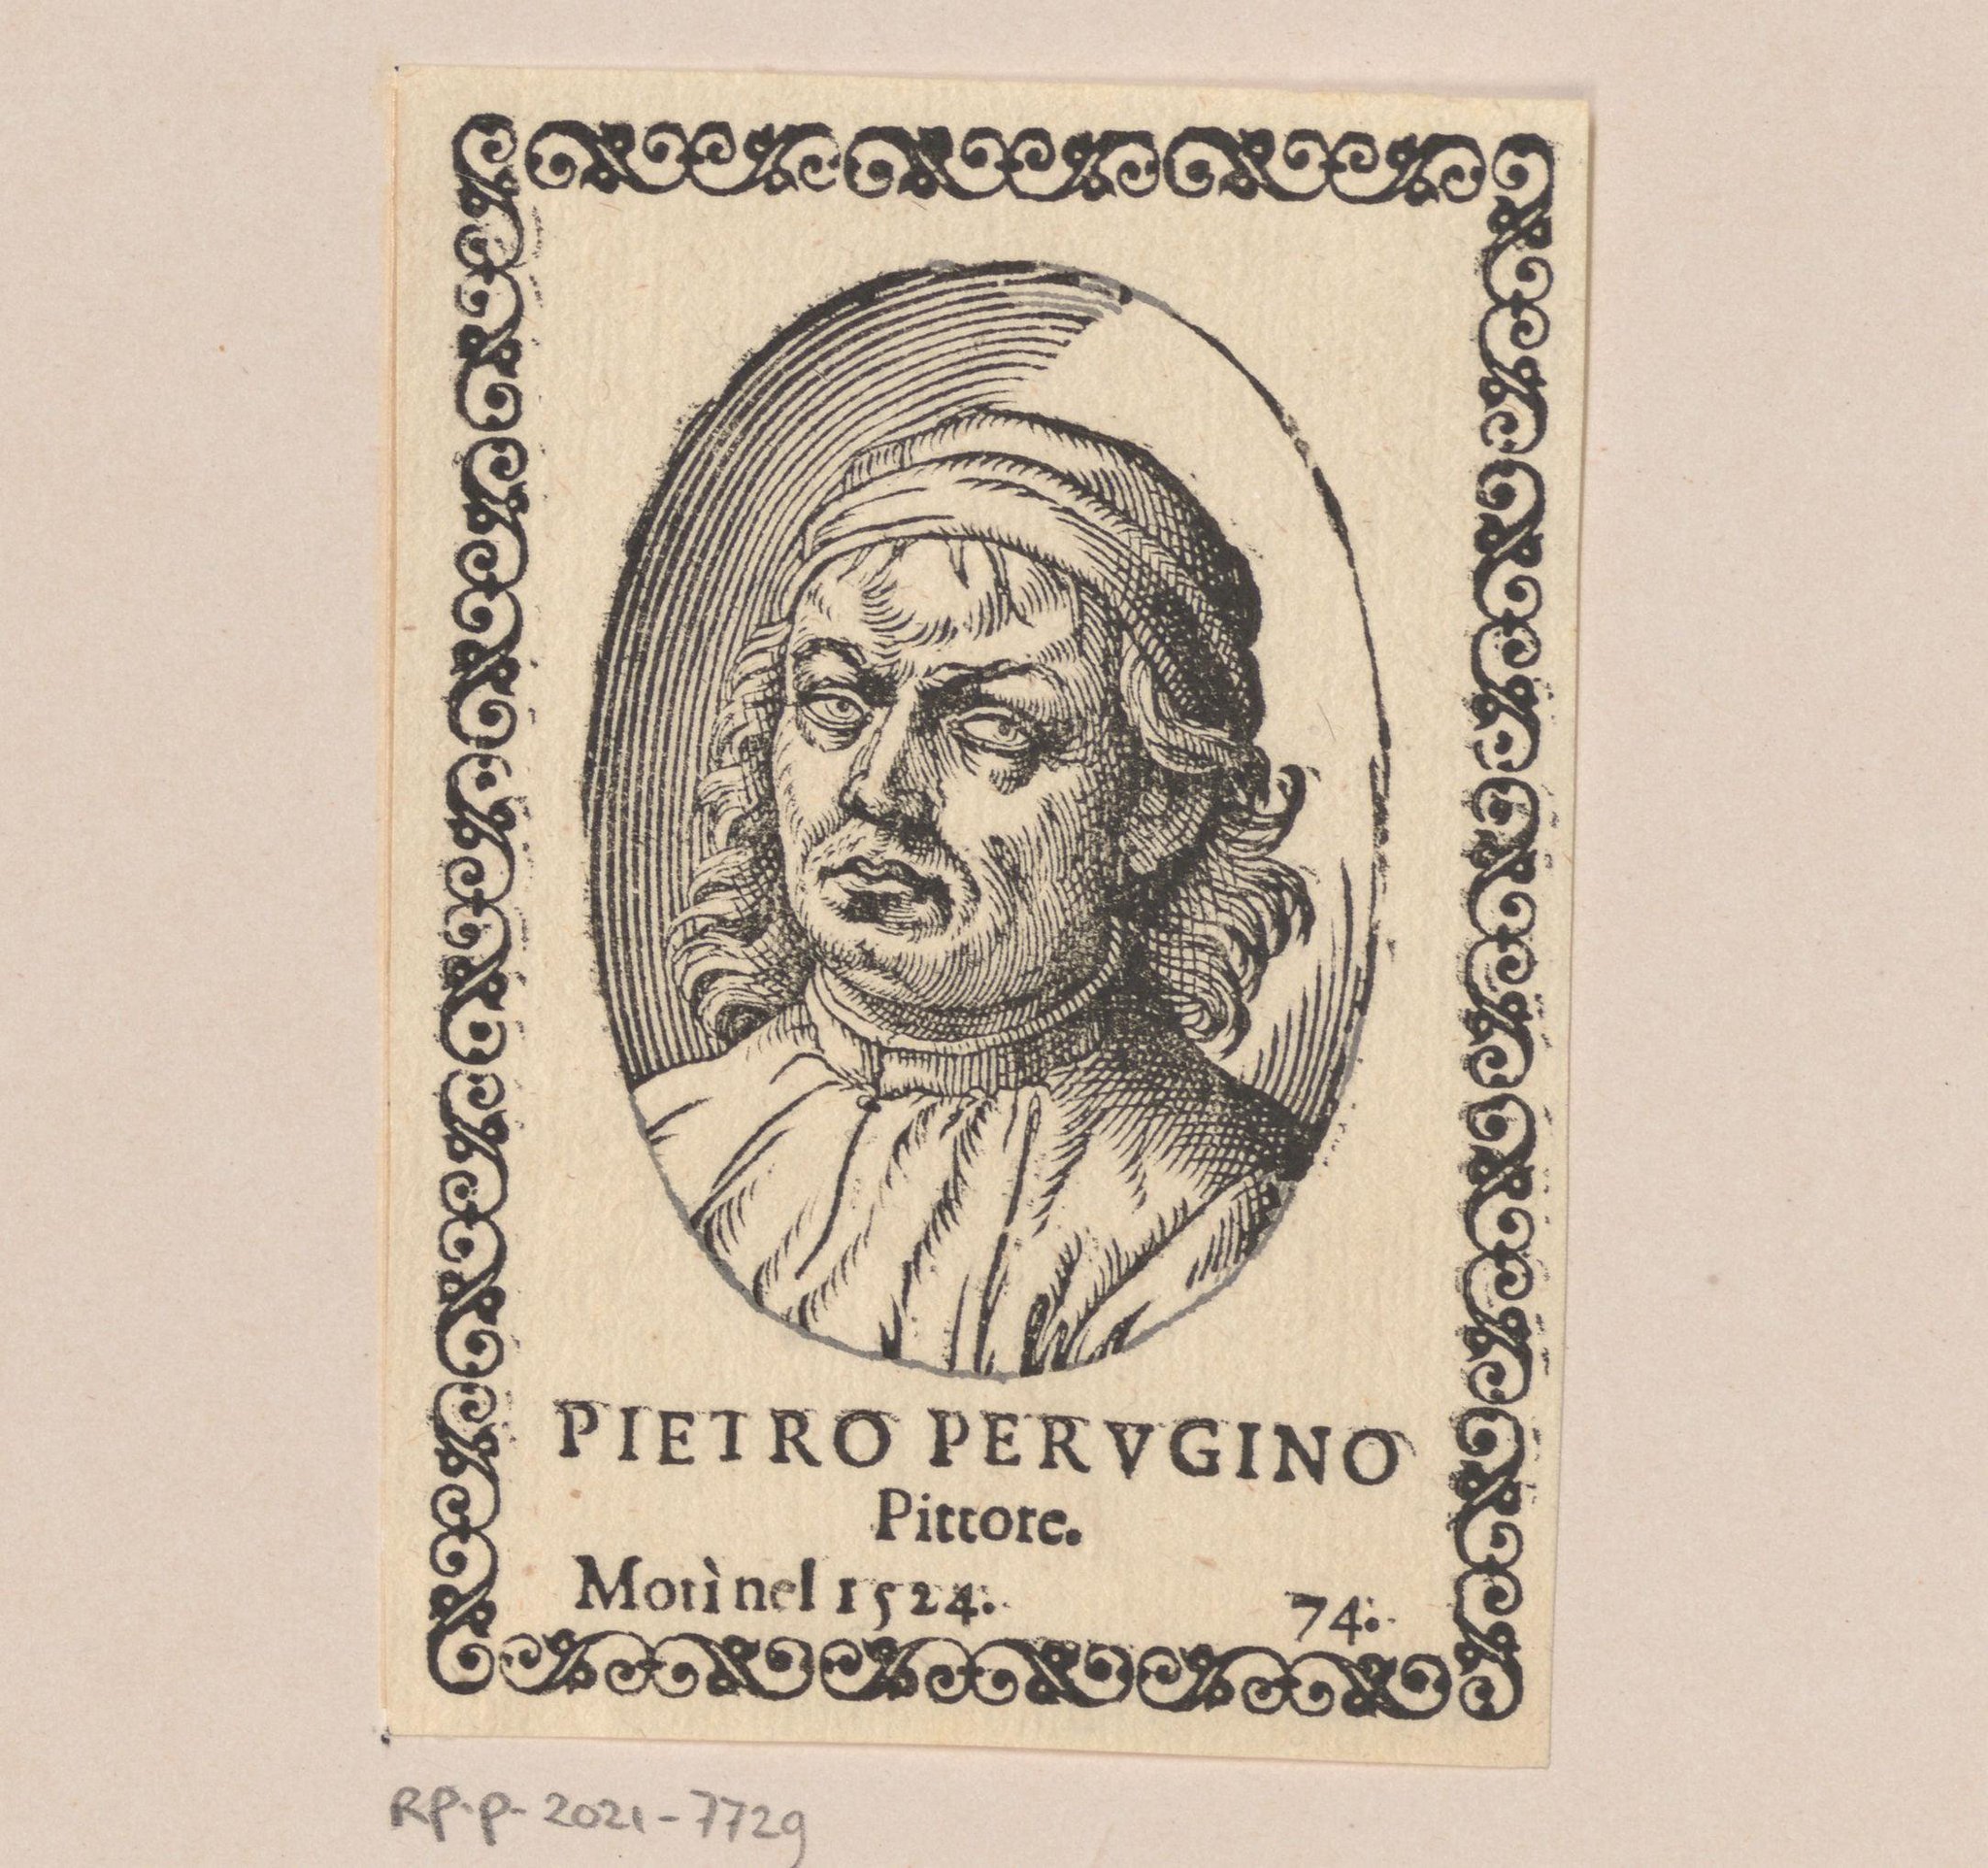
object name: print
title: Portret van Pietro Perugino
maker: cristoforo coriolano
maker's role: print maker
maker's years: 1540-1610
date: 1568-1647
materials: paper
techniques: letterpress printing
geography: italy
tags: pietro perugino, adult man, historical persons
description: Prent komt vermoedelijk uit een editie van Vasari's 'Vite'. Vergelijkbare prenten zijn bijvoorbeeld gebruikt in de edities uit 1568 en 1647.